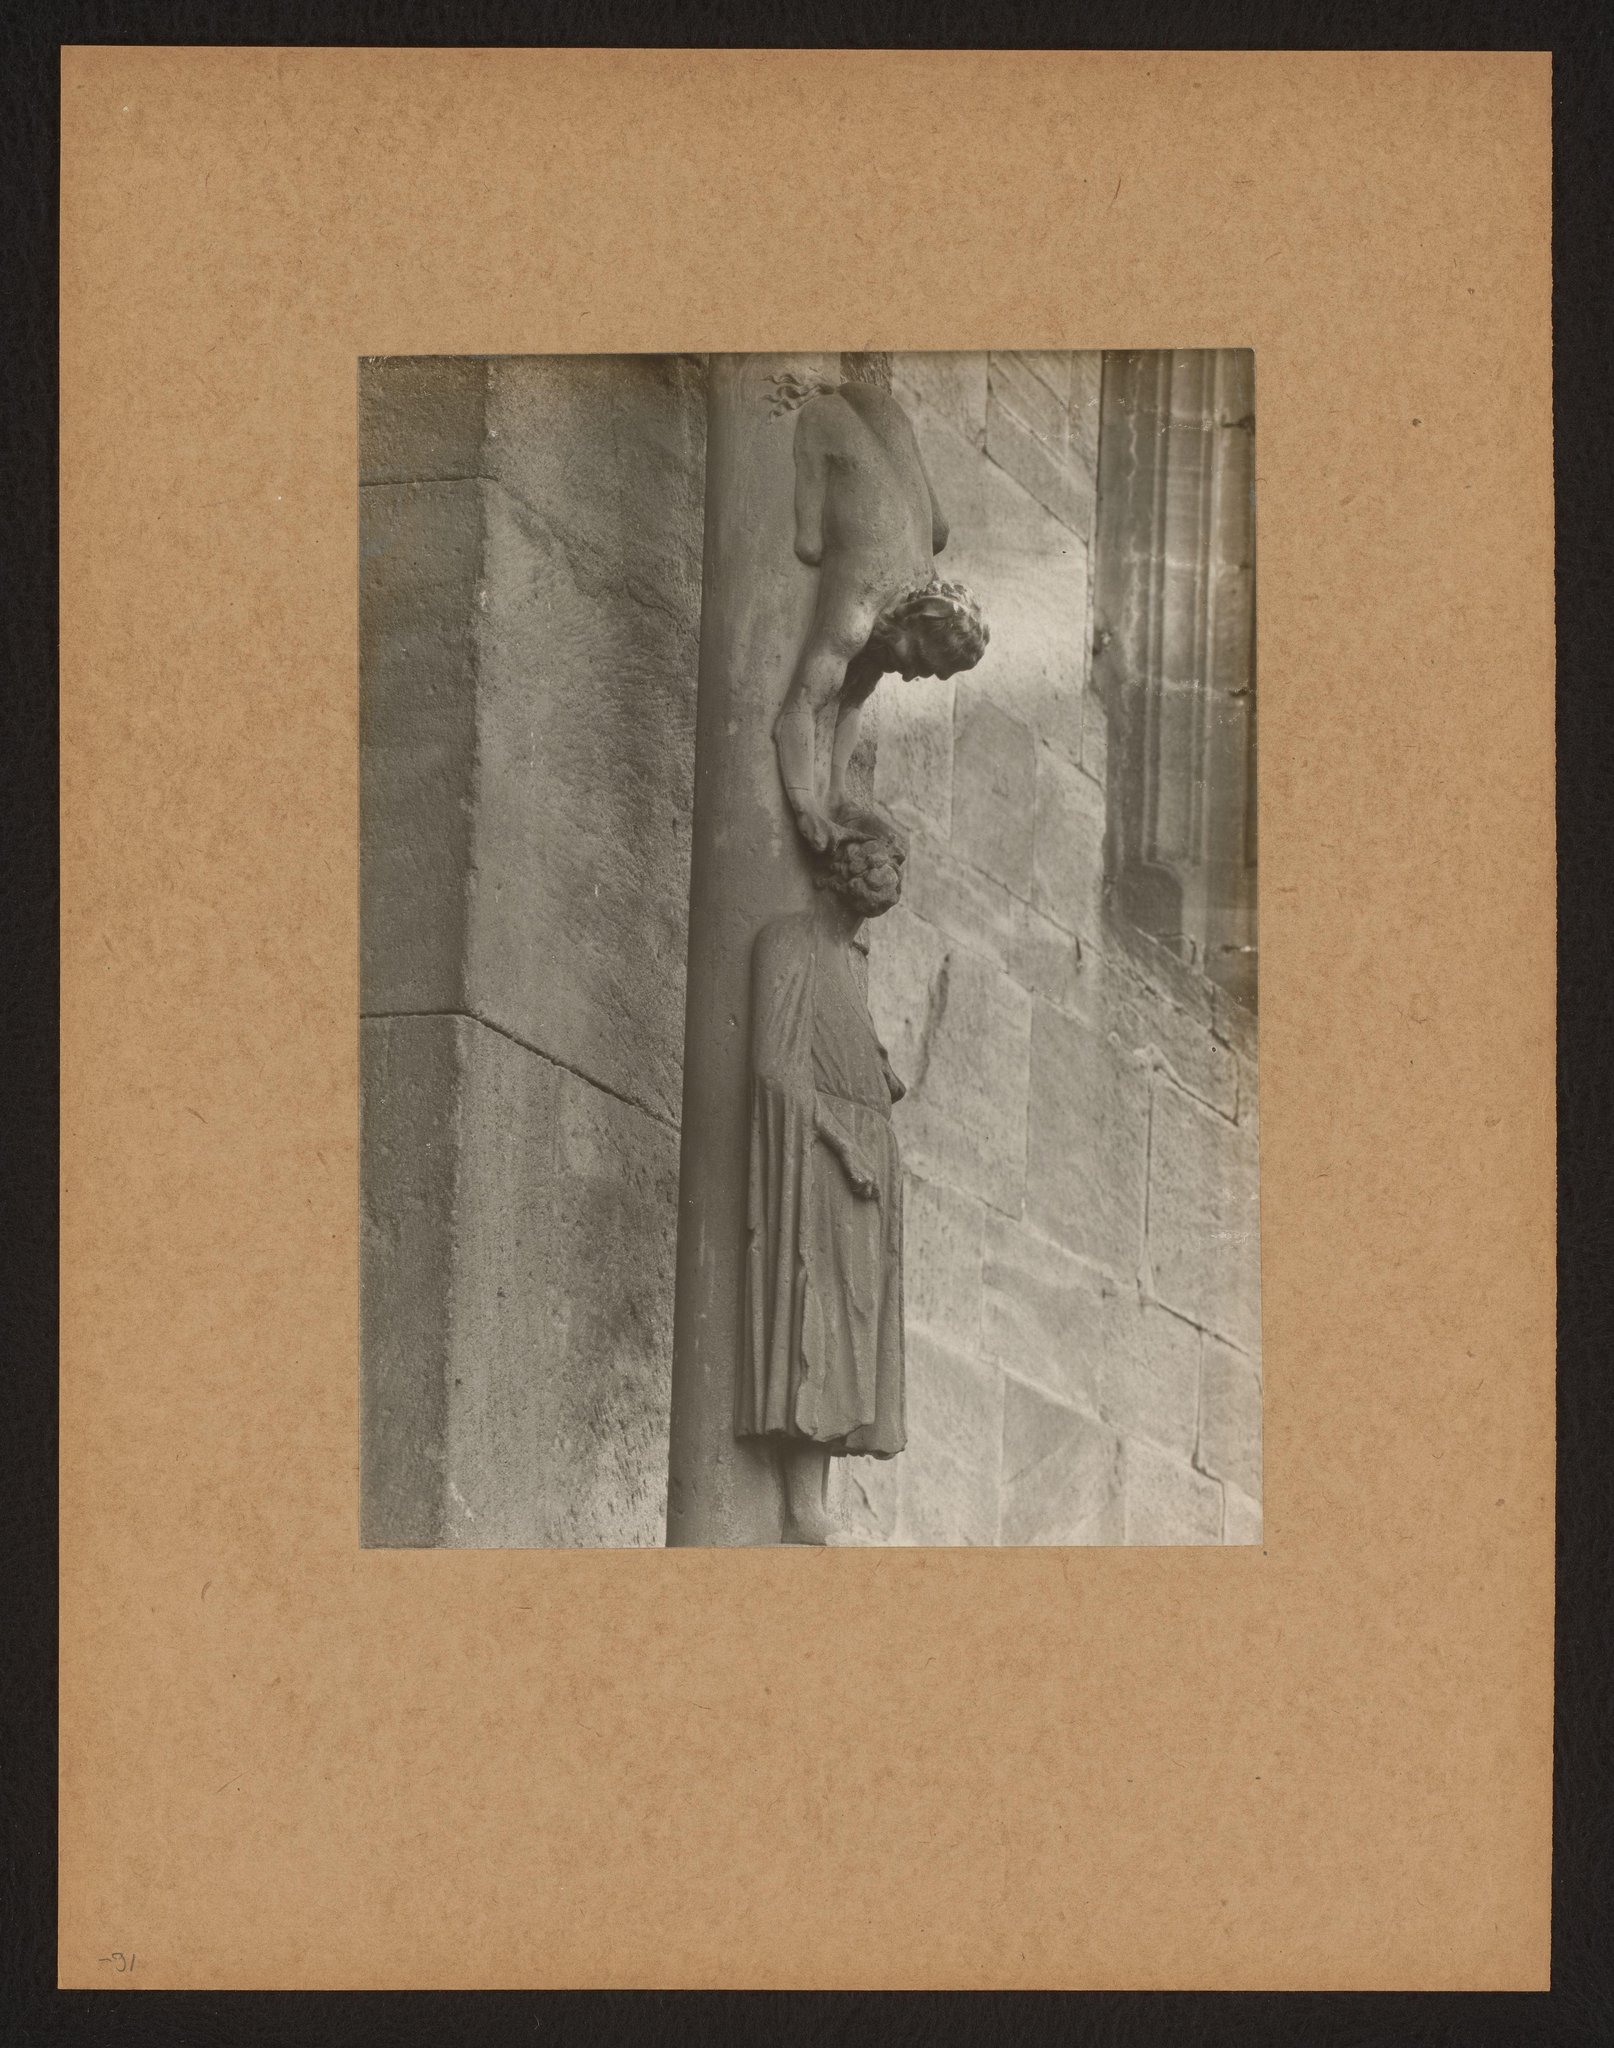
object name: photograph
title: Fürstentor Judassäule, die Figur v.l.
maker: Anonymous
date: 1900-1920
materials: paper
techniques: gelatin silver print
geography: bamberg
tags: church (exterior)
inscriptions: number: ‘94.’